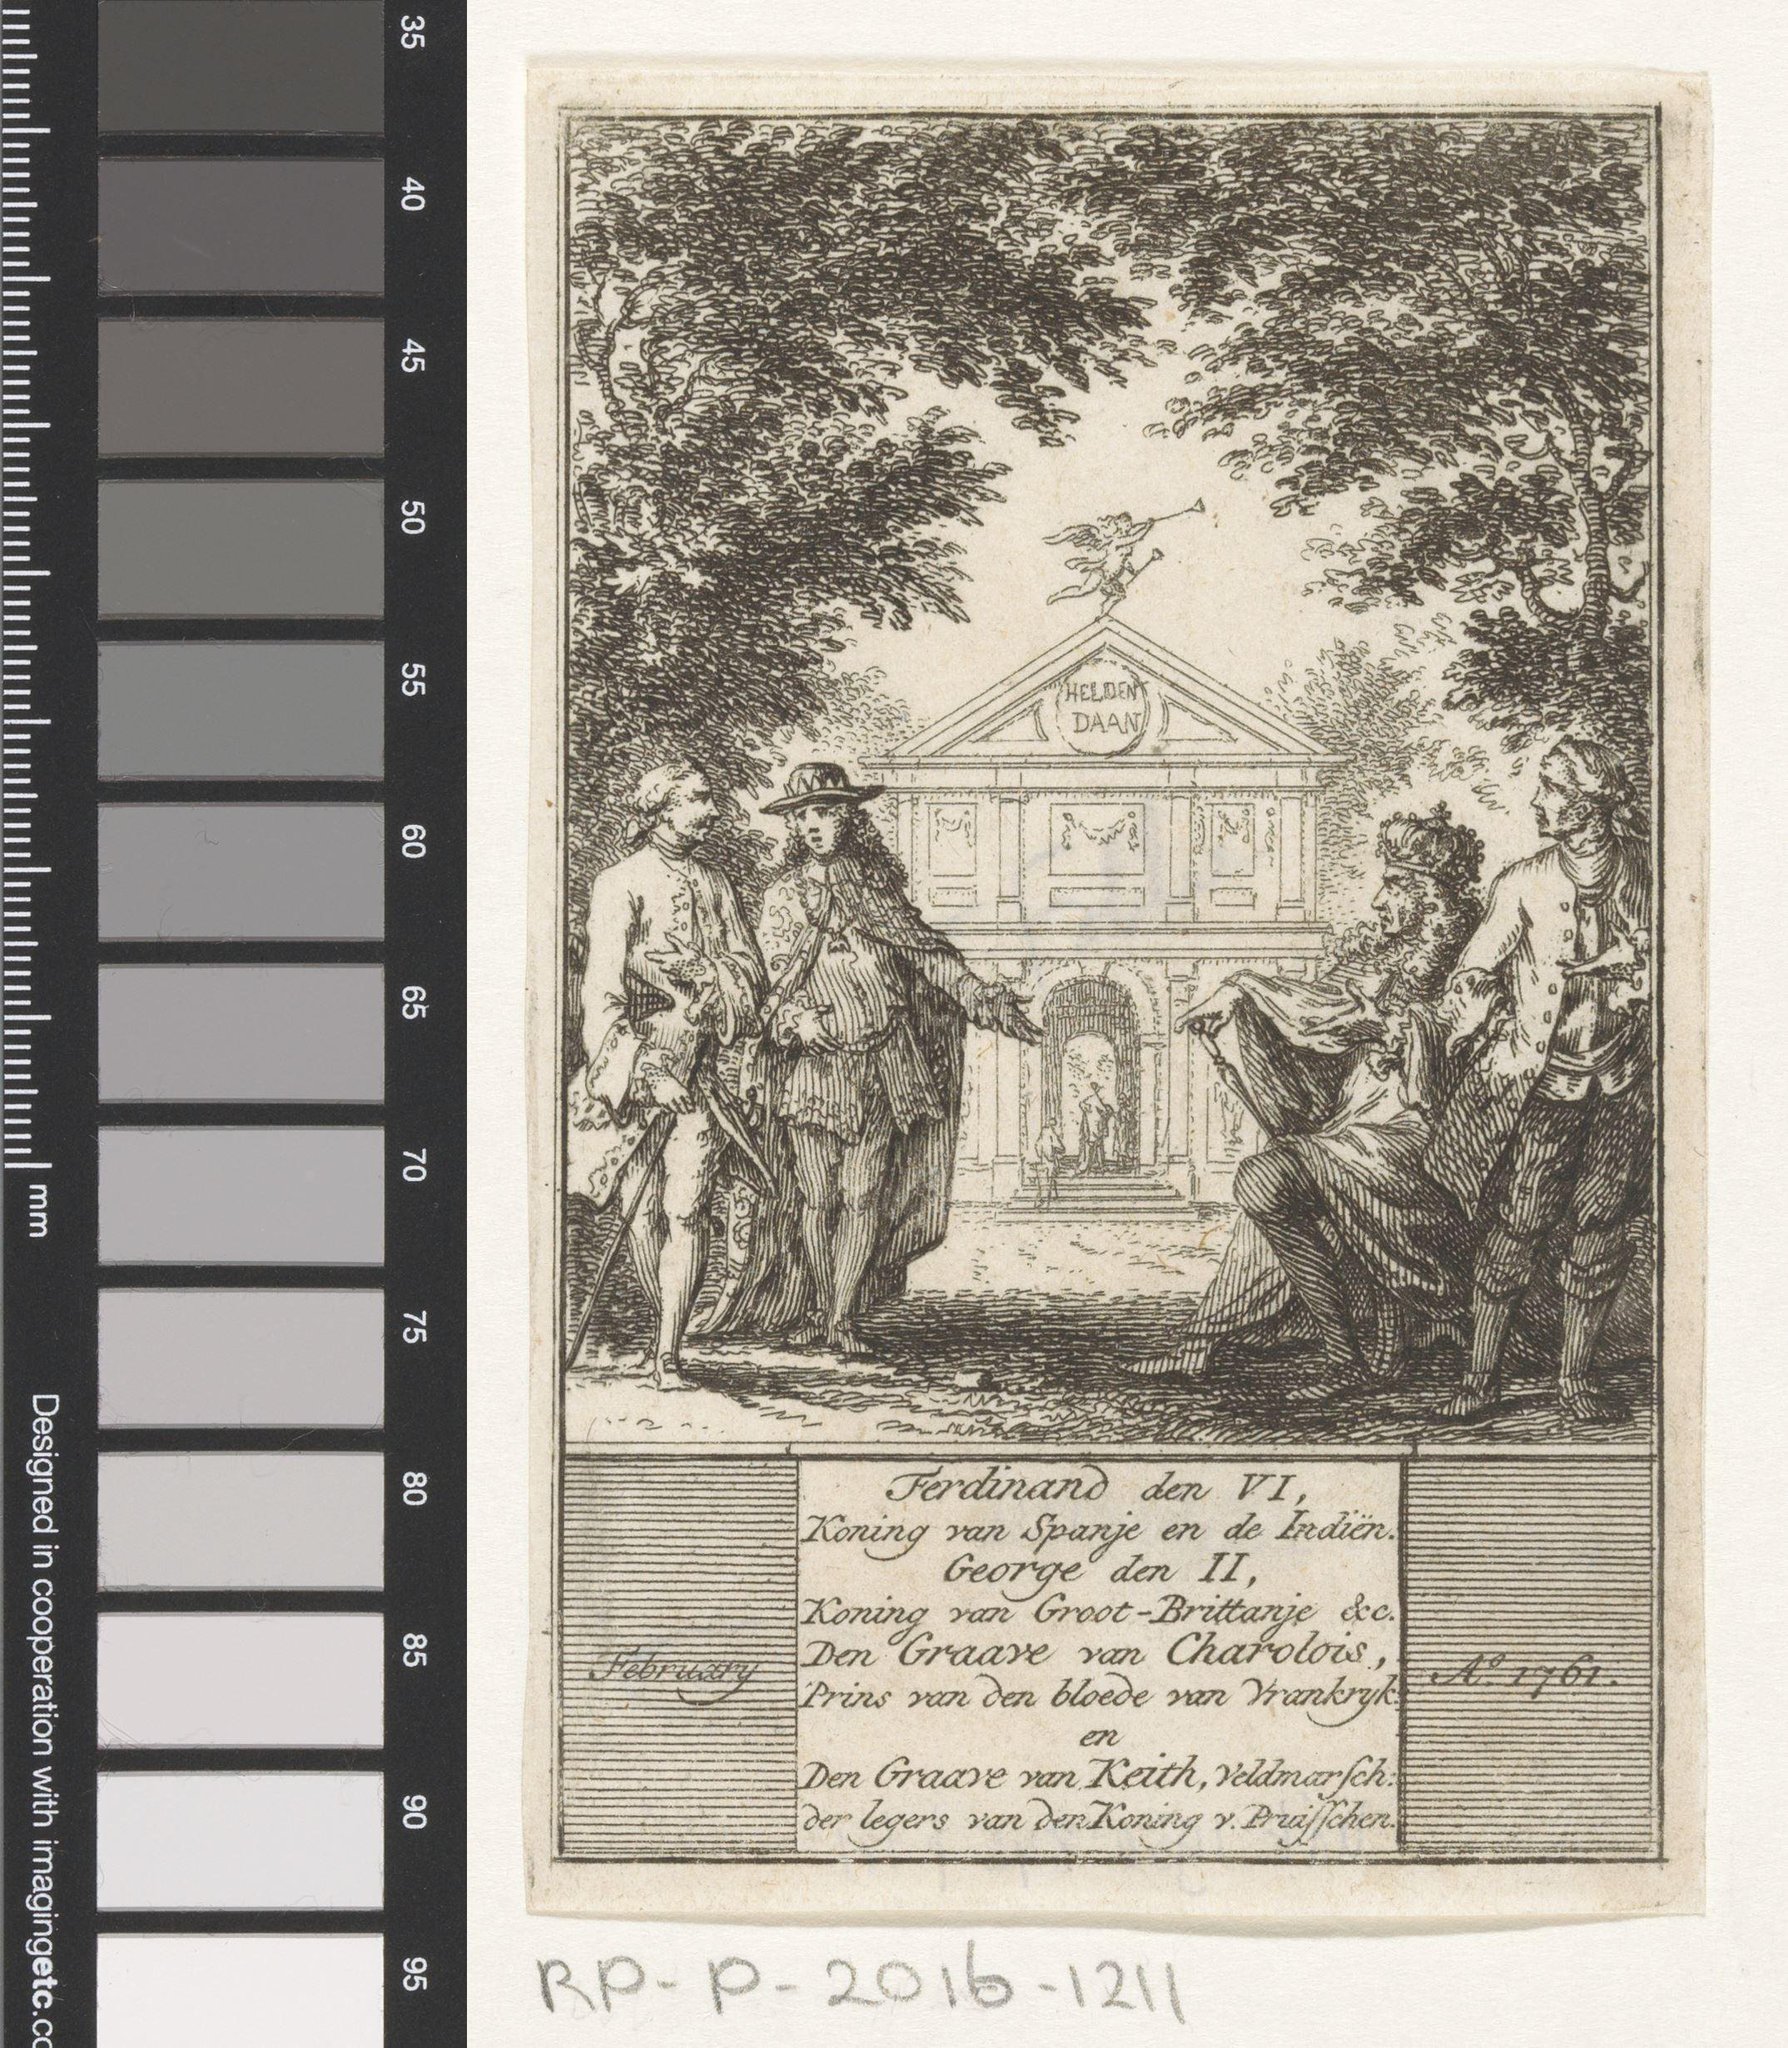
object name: print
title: Ferdinand den VI, Koning van Spanje en de Indiën, George den II, Koning van Groot-Brittanje &c, Den Graave van Charolois, Prins van den bloede van Vrankryk: en Den Grave van Keith, Veldmarsch; der legers van den Koning v. Pruisschen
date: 1702-1761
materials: paper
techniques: etching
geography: amsterdam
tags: ferdinand vii (koning van spanje), conversation, dialogue; conversation piece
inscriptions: collector's mark: Lugt 2228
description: In tweetallen zitten de koningen Ferdinand VI van Spanje en George II van Groot-Brittannië en de graaf van Charolais en Jacob (of James Francis Edward) Keith tegenover elkaar. In de achtergrond een gebouw met Fama en de tekst Heldendaan. Aan de onderzijde vermeld: February / Ao 1761.